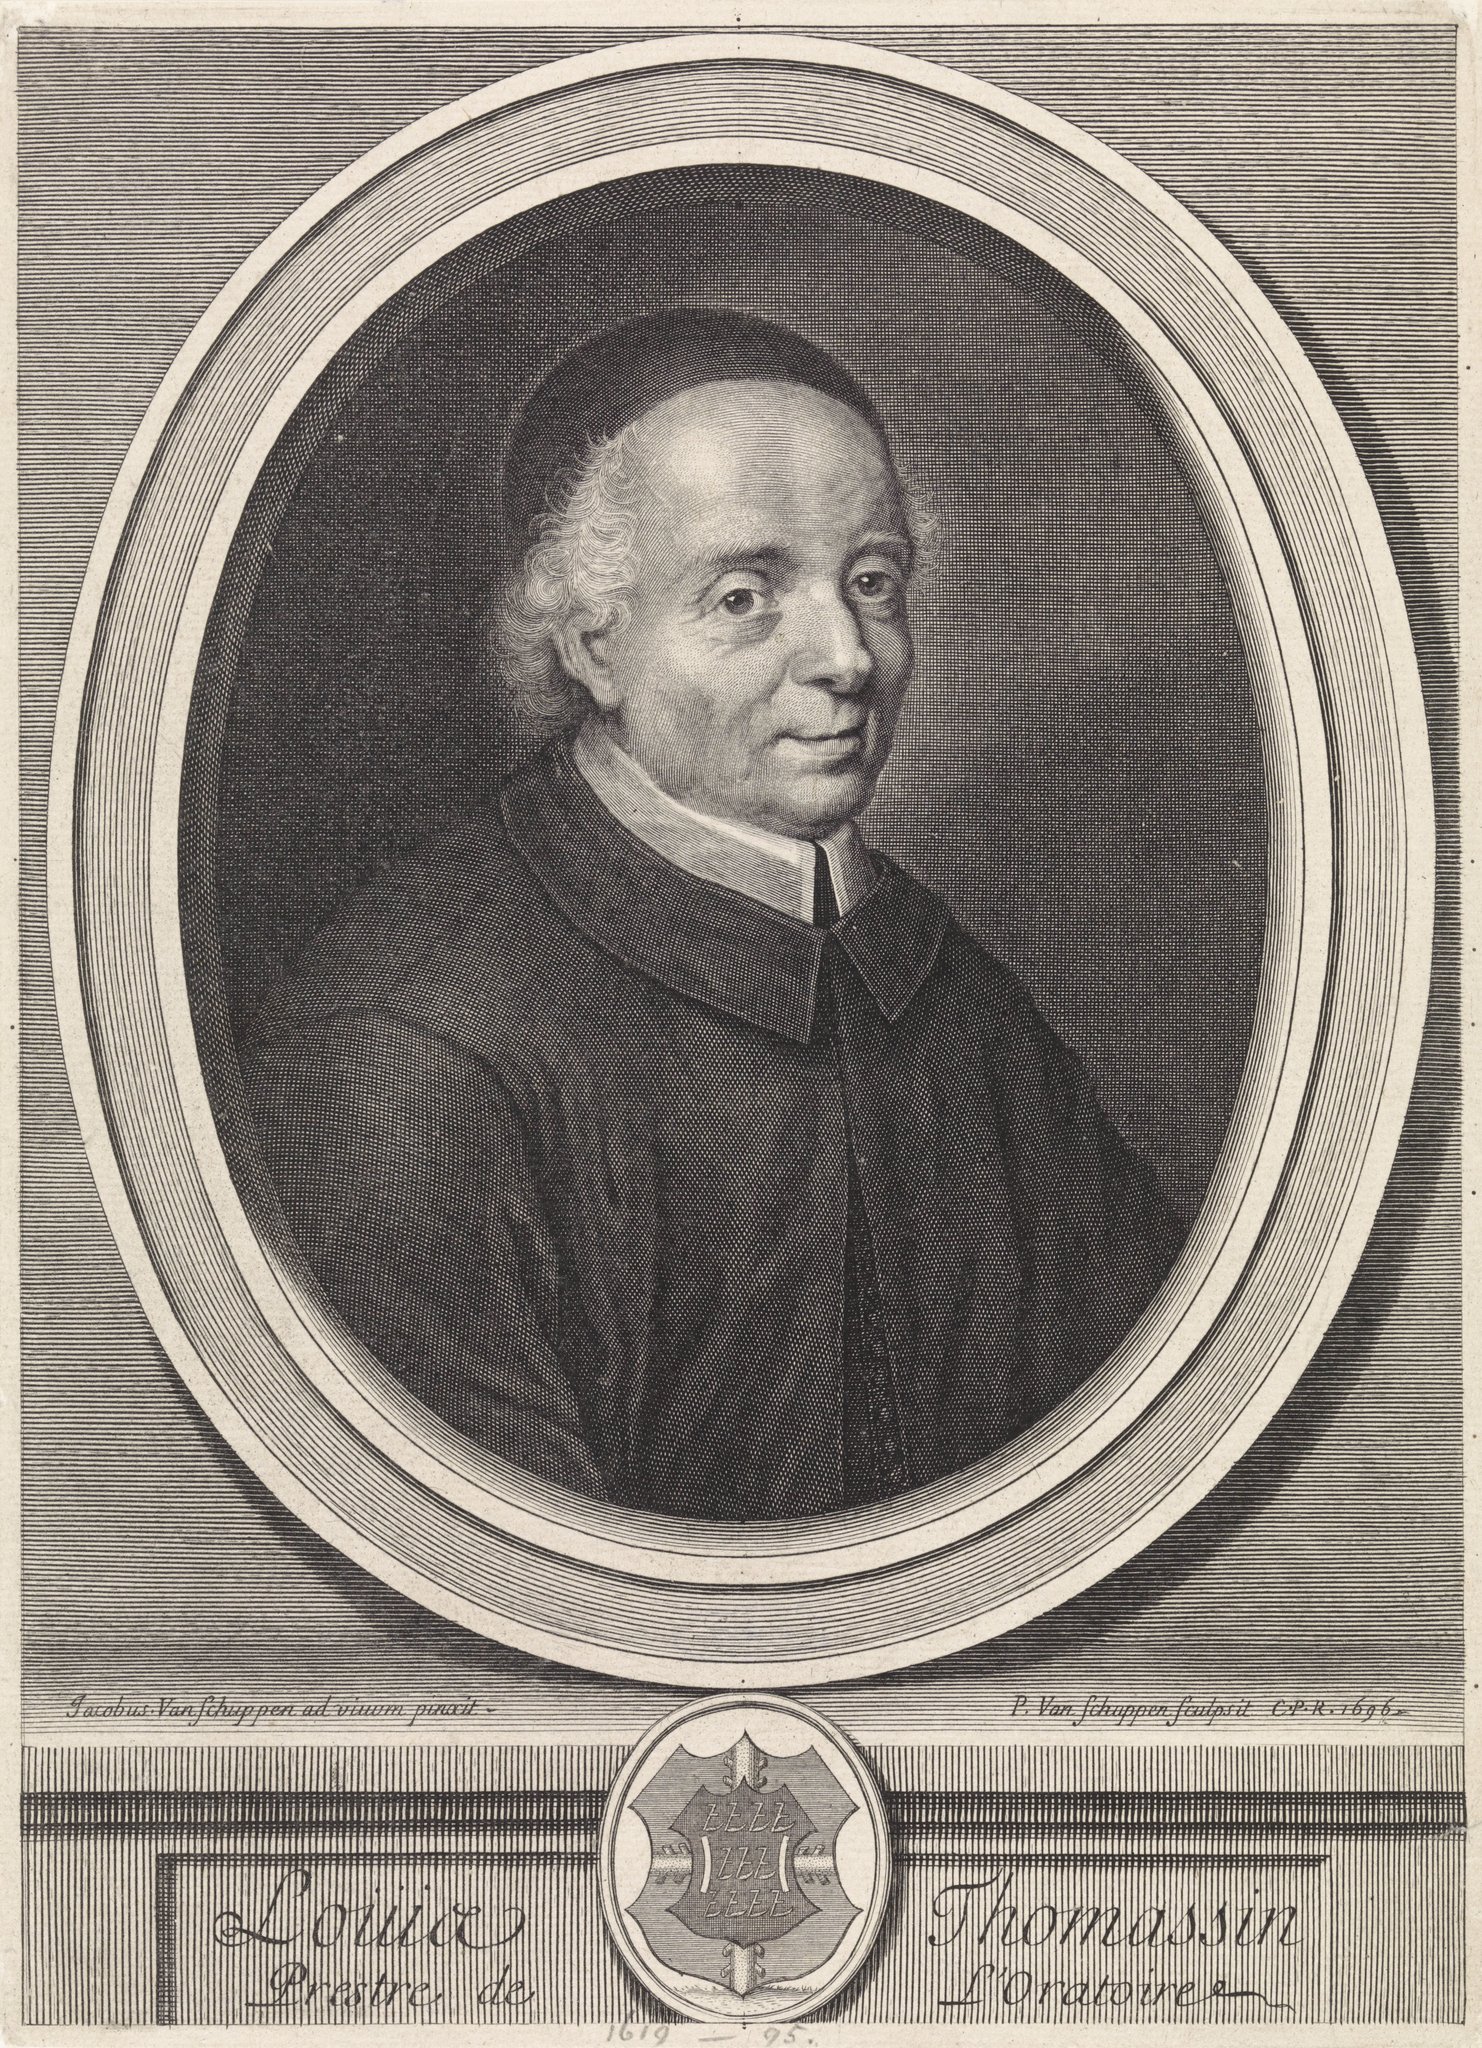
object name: print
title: Portret van de theoloog Louis Thomassin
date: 1612-1696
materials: paper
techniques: engraving, etching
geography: paris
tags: paris, priest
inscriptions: inscription: ‘Lex. universale Hebraicum, met Barat juif, c. 1700’, collector's mark: Lugt 2228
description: Prent mogelijk gebruikt in: Louis Thomassin. Glossarium universale hebraicum. Parijs: e typographia regia, 1697.